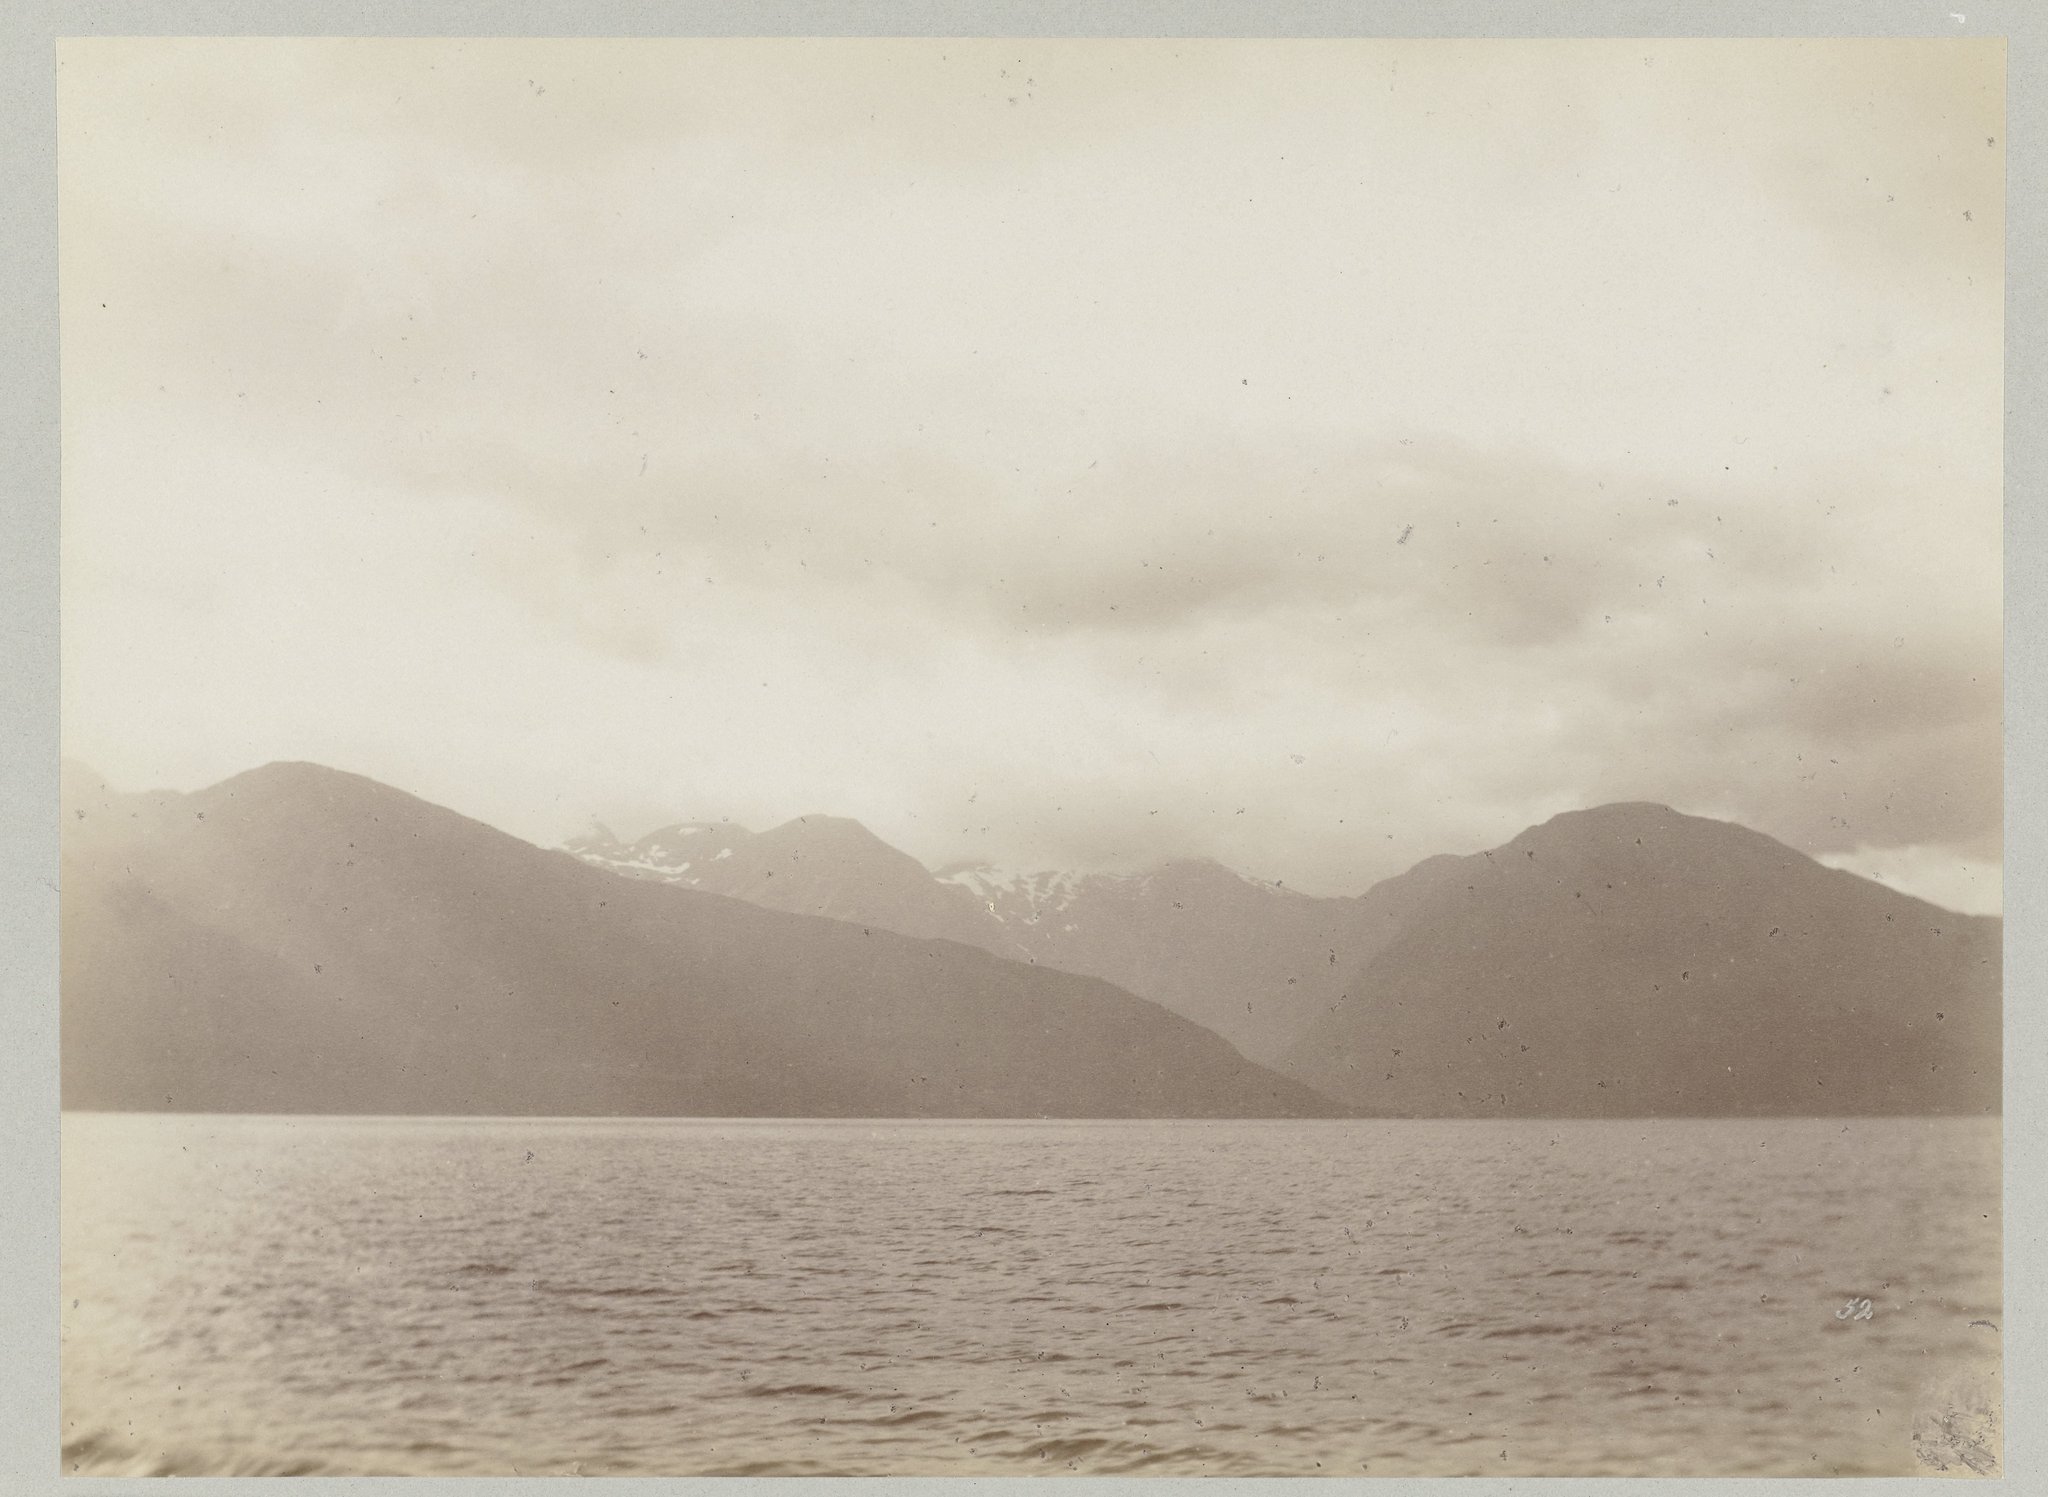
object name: photograph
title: Im Sognefjord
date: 1807-1889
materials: cardboard, paper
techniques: albumen print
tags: wilhelm ii (keizer van duitsland), norway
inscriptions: number: ‘52’, number: ‘20’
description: De afdruk van de foto is rond, het papier vierkant